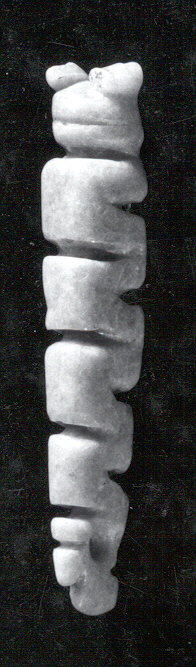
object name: pendant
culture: atlantic watershed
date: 301-800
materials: jade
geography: costa rica